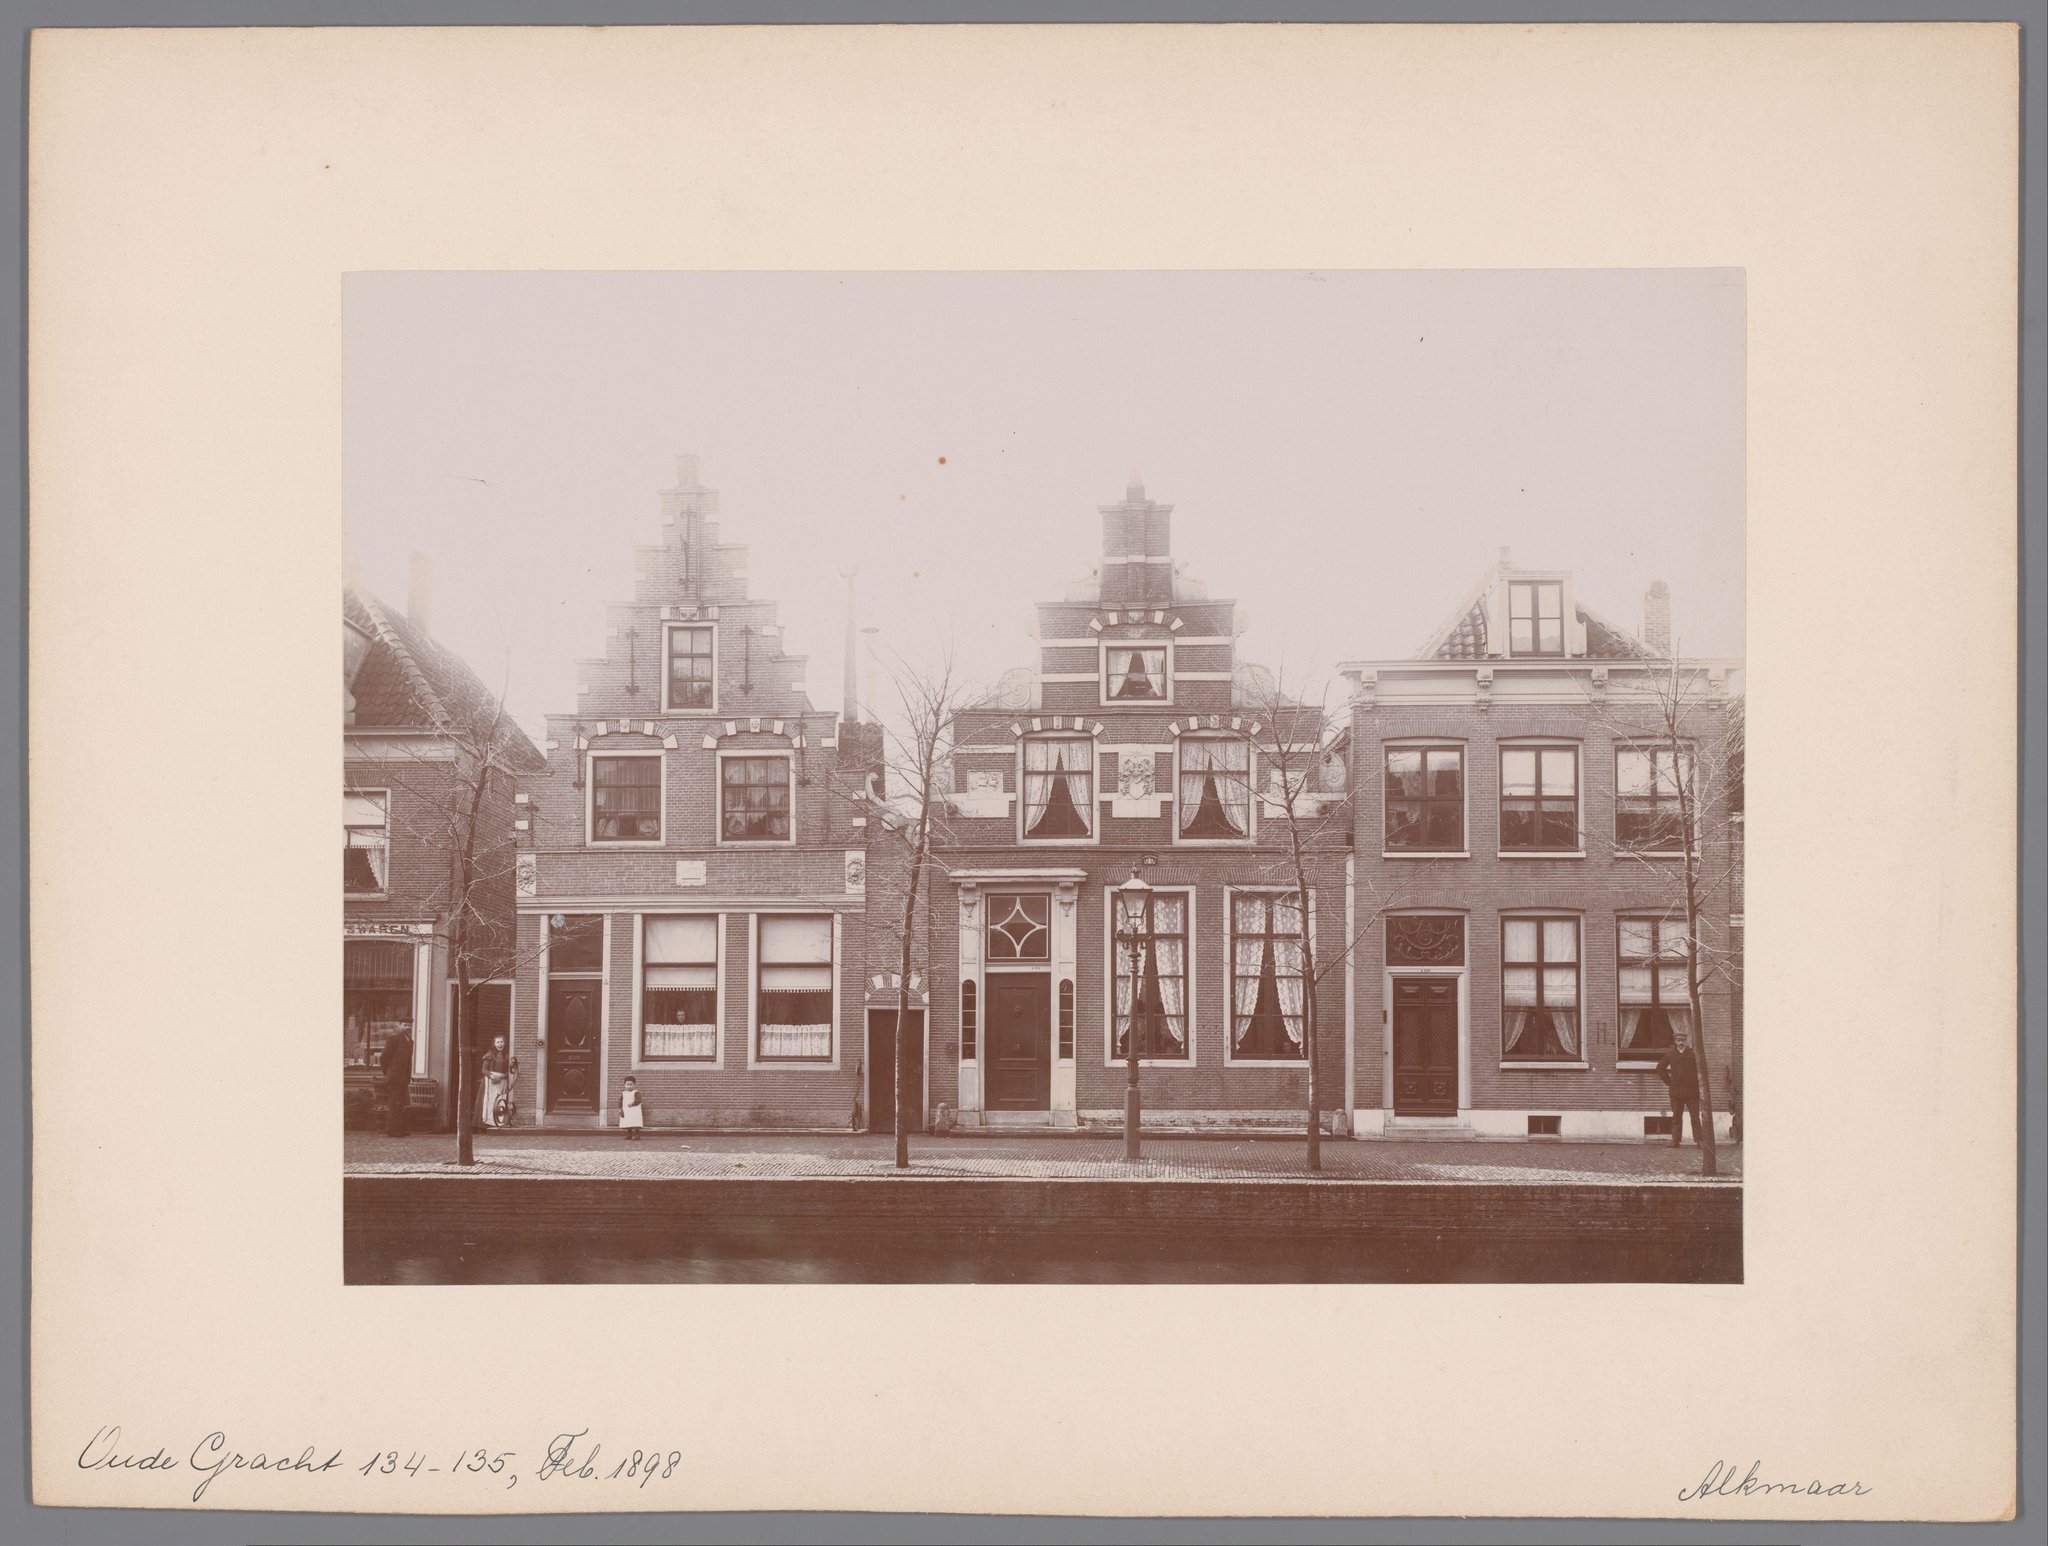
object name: photograph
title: Gezicht op Oude Gracht 134-136 te Alkmaar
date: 1898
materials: cardboard, photographic support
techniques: gelatin silver print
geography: oude gracht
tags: urban housing, façade (of house or building)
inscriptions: annotation: ‘Oude Gracht 134-135. Feb. 1898/ Alkmaar’, annotation: ‘Alkmaar (N.H.)/ Huizen No. 134-135 op de oudegracht/ feb 1898’